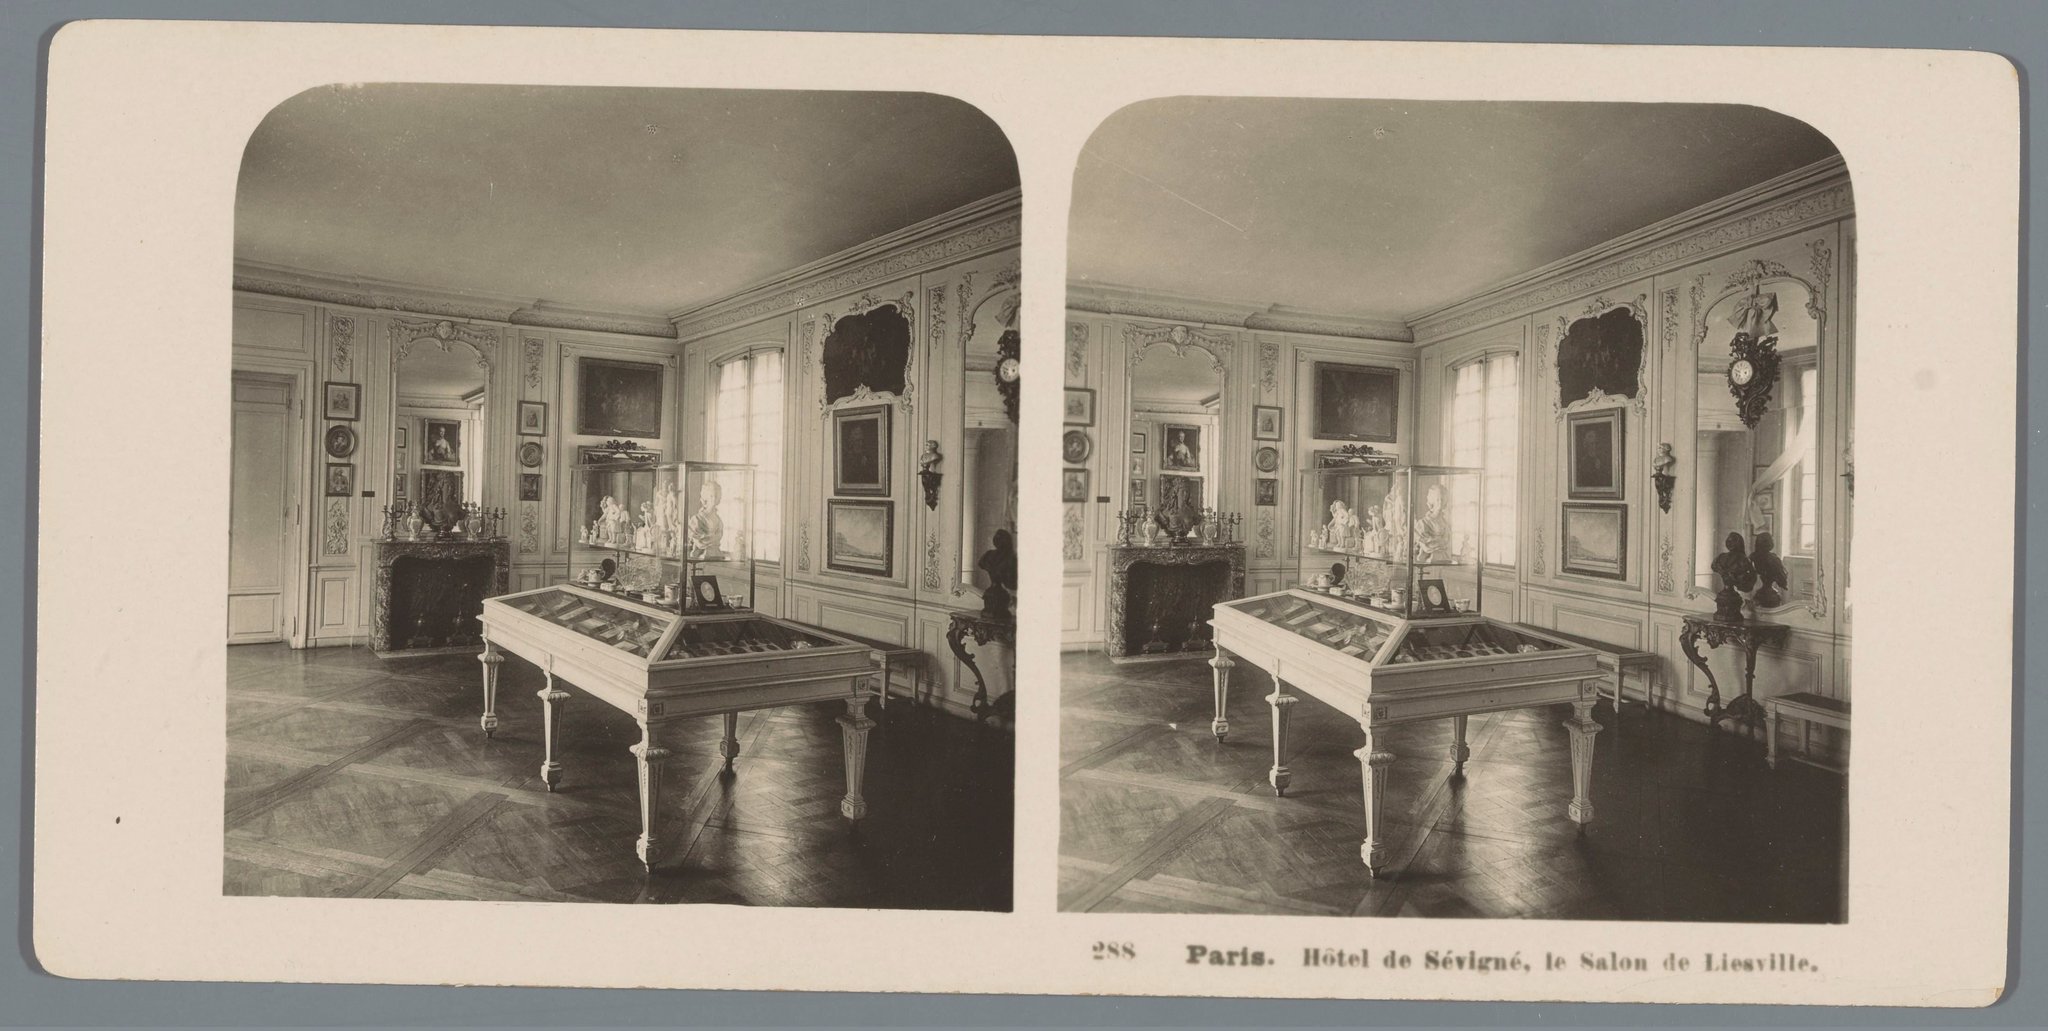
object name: stereograph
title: Interieur van de Salon de Liesville in het Hôtel de Sévigné te Parijs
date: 1904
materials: cardboard, photographic support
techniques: gelatin silver print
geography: paris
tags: art collection, art gallery, hôtel, i.e. small palace in city - aa - civic architecture: inside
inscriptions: inscription: ‘Neue Photographische Gesellschaft A.-G. Steglitz-Berlin 1904.’, number: ‘288’